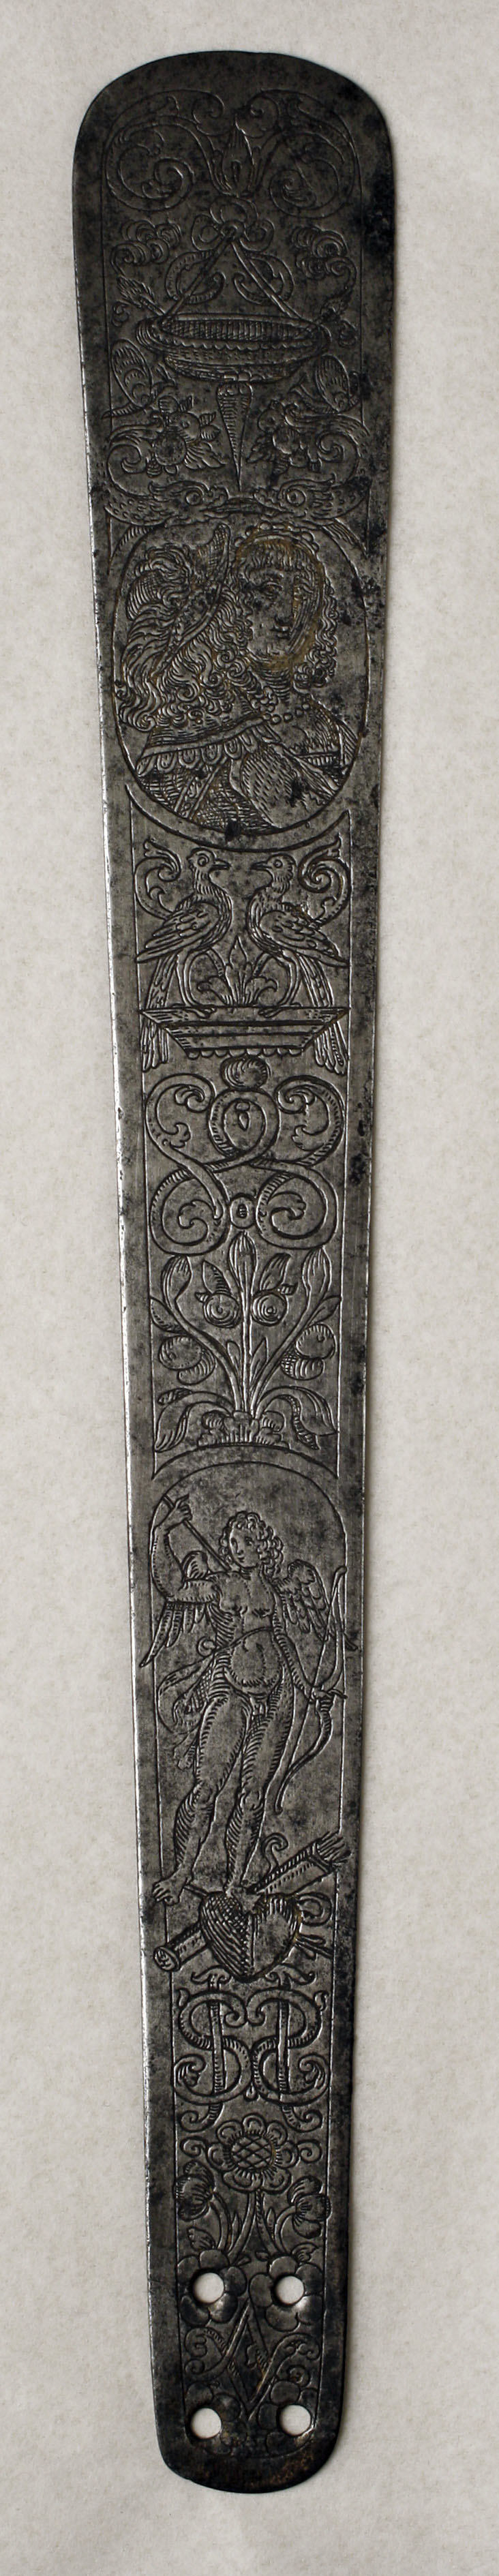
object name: busk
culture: french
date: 1601-1700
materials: metal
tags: bow and arrow,men,cupid,venus